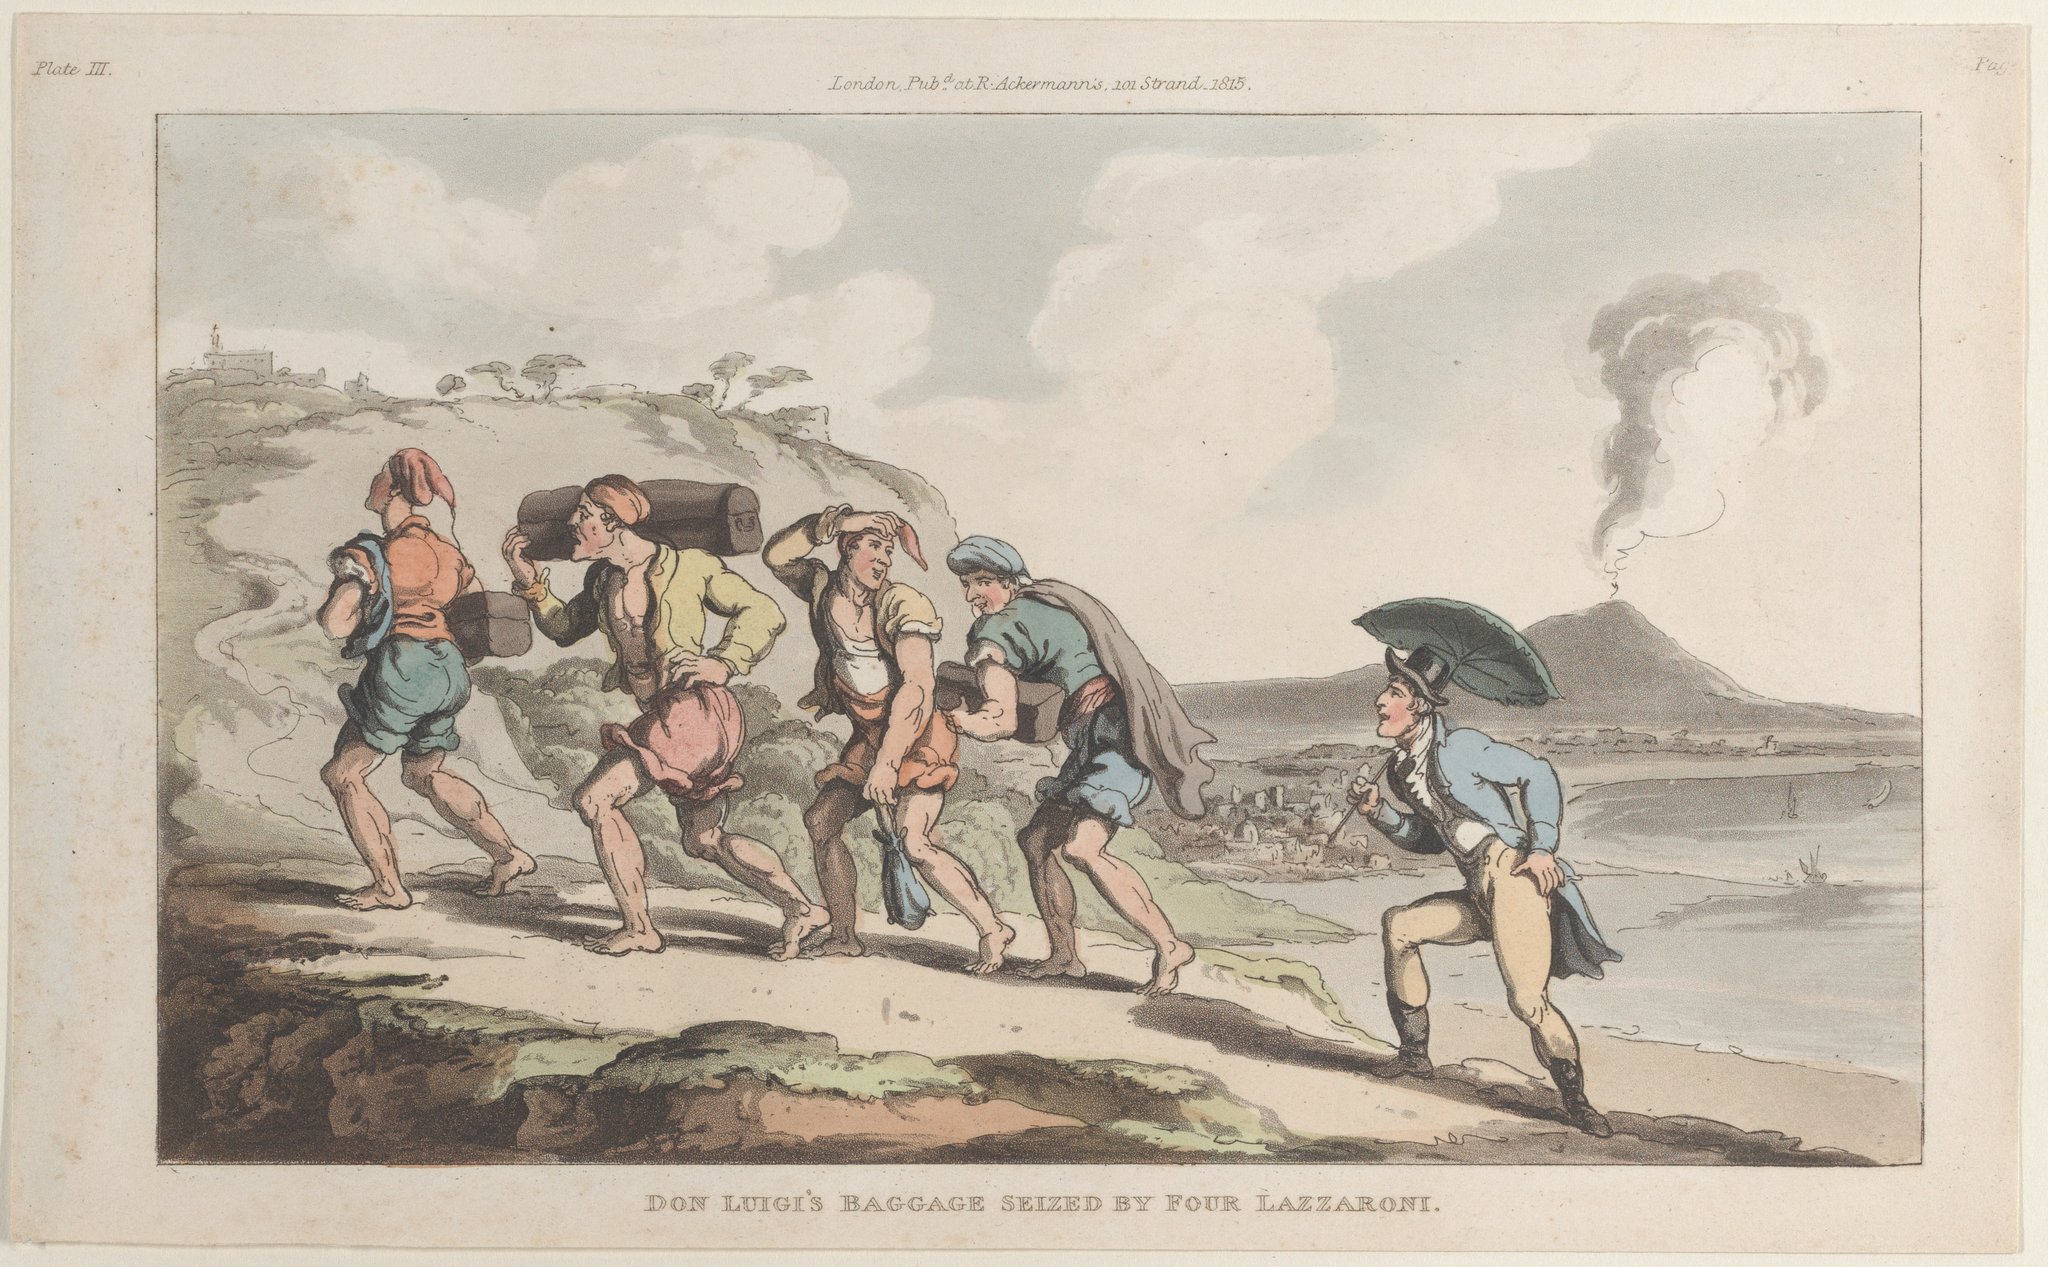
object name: print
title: Don Luigi's Baggage Seized by Four Lazzaroni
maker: thomas rowlandson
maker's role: artist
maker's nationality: british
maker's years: 1757-1827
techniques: aquatint, etching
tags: men